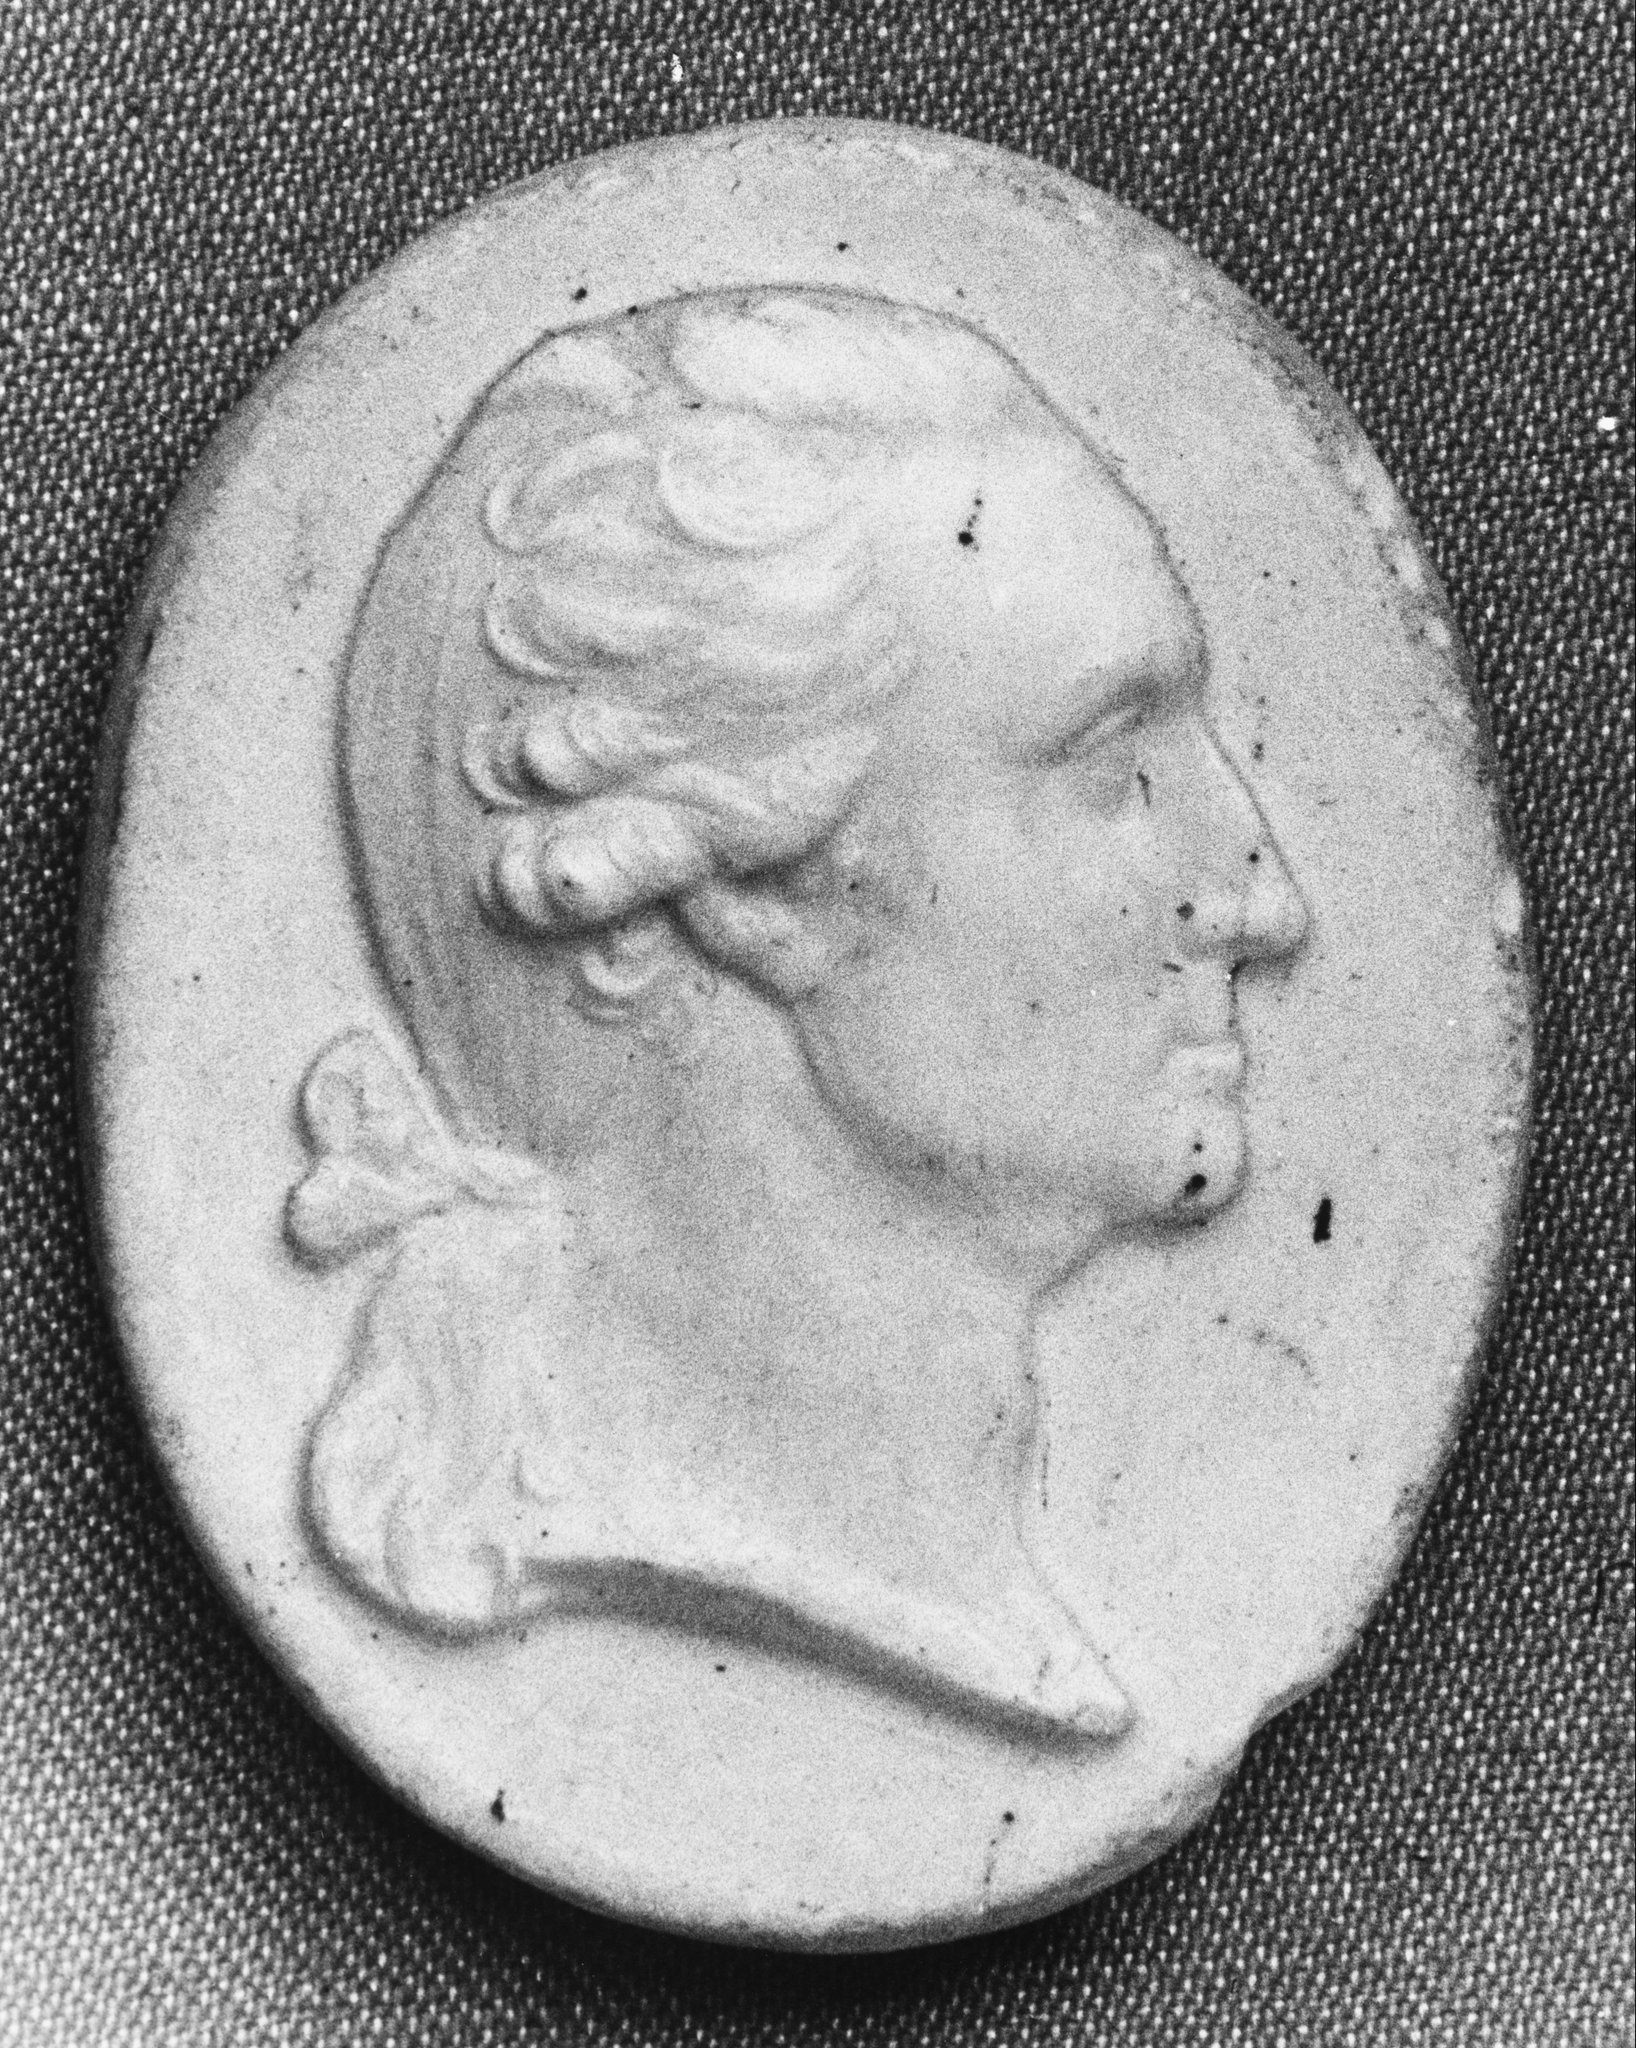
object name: medallion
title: George Washington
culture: french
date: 1840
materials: porcelain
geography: france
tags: george washington,men,profiles